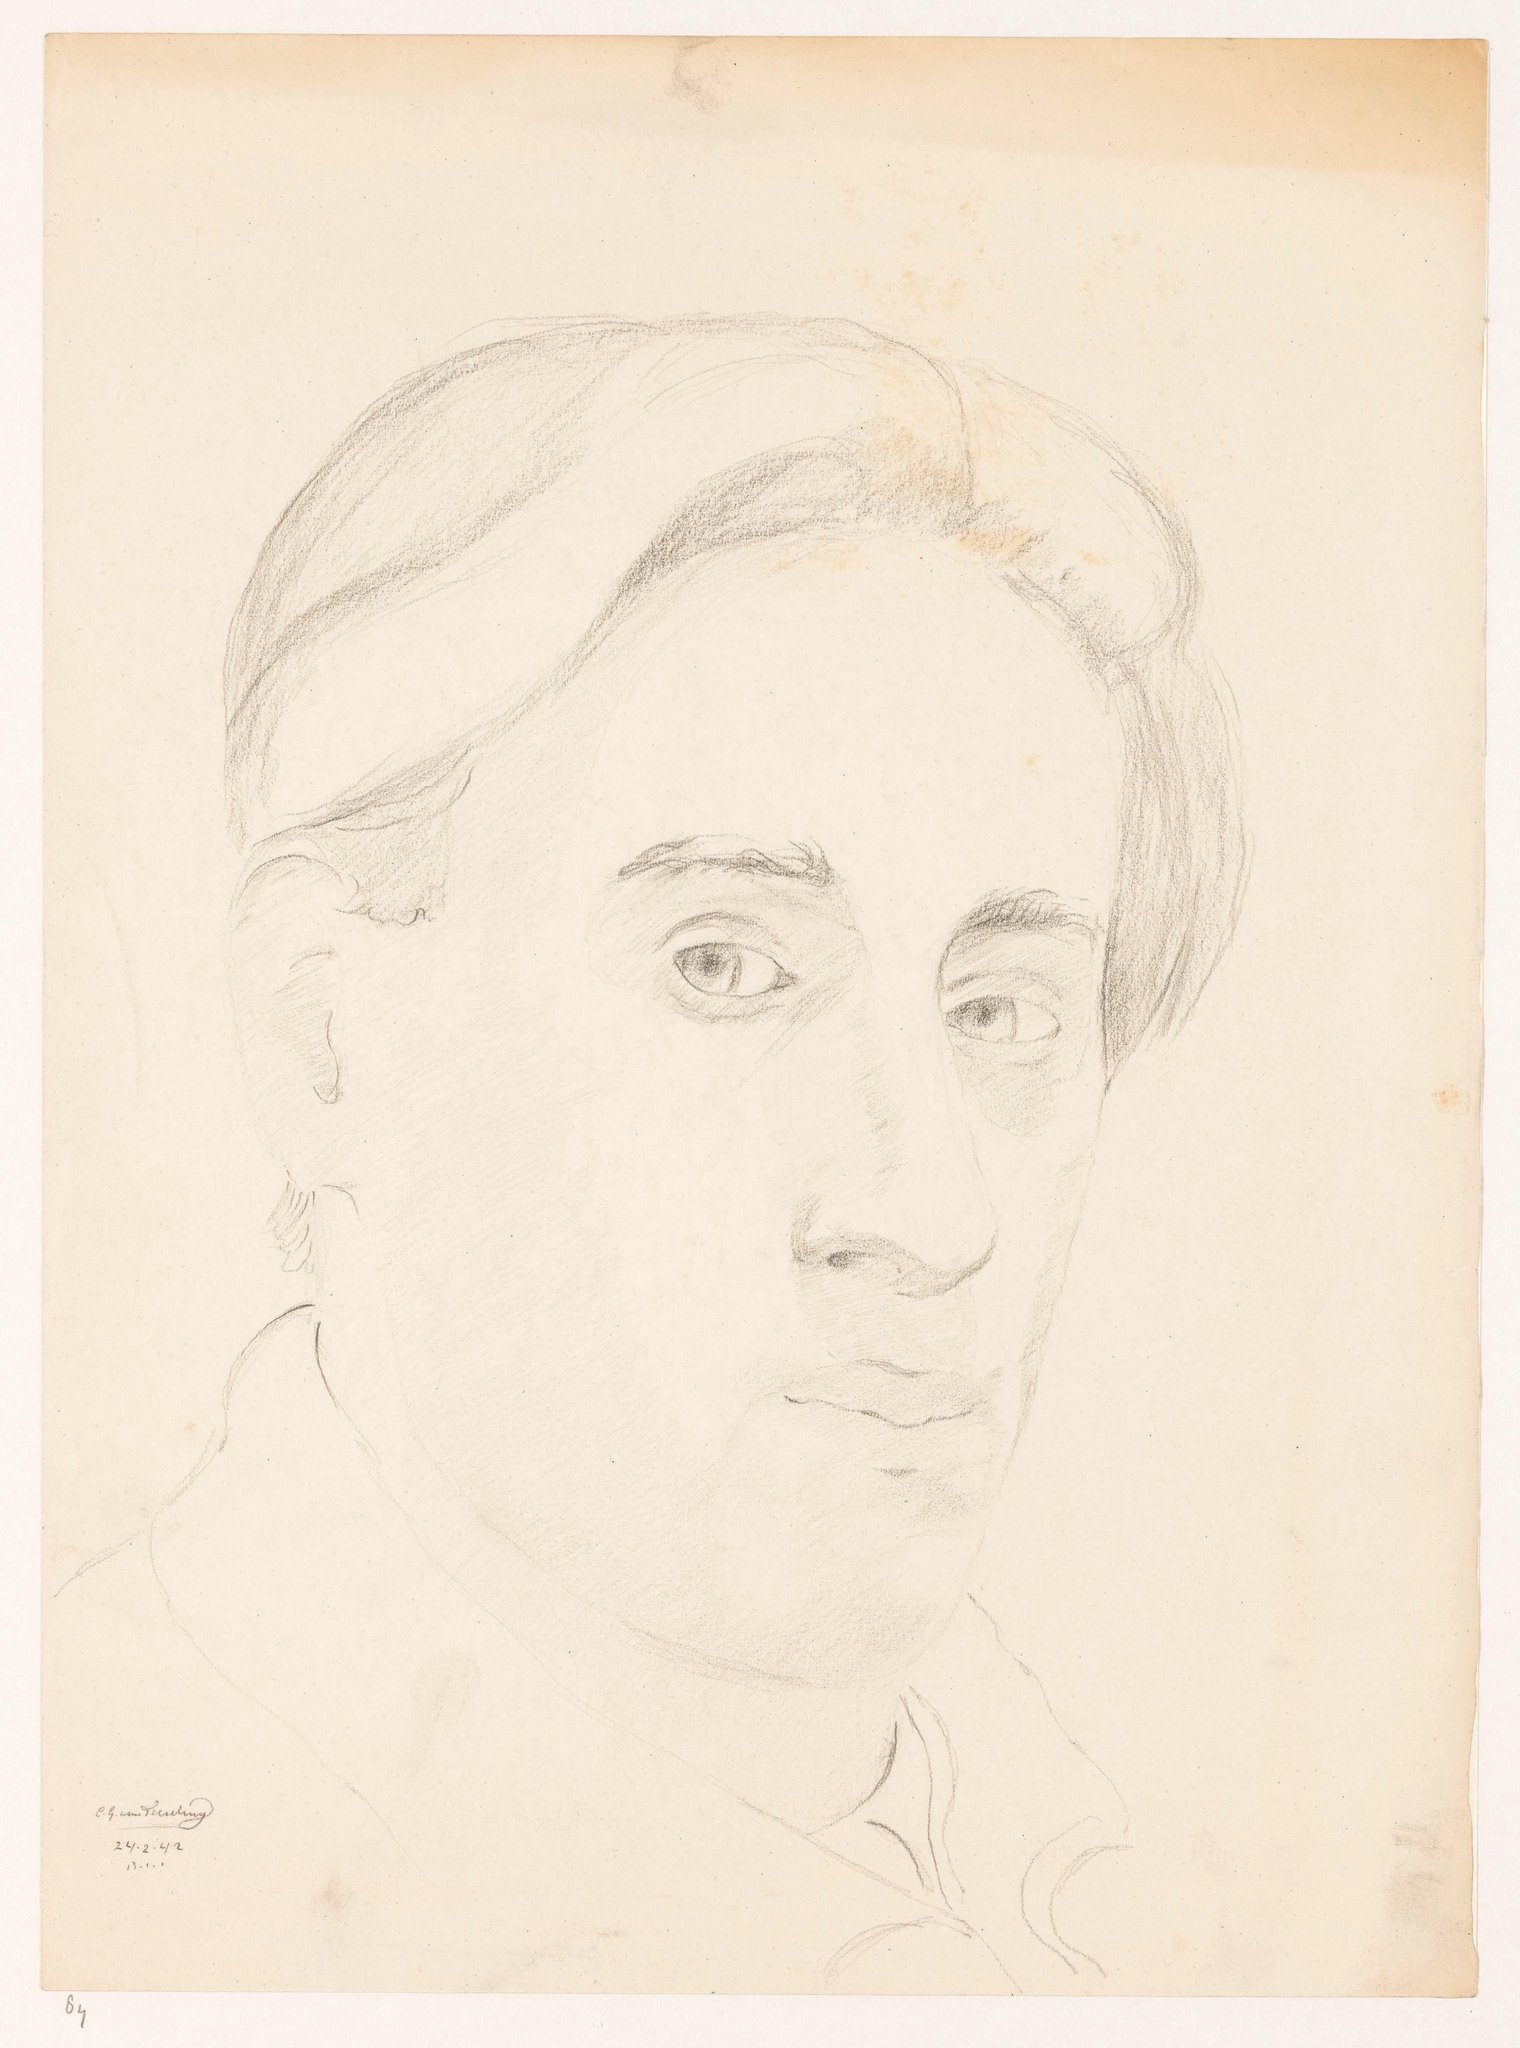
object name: drawing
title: Zelfportret: B-1-1, 24 februari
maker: cor van teeseling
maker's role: draughtsman, sculptor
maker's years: 1915-1942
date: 1942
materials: paper, pencil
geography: weteringschans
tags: amsterdam, draughtsman, sculptor, cor van teeseling, historical persons, prisoner in cell or locked place, portrait, self-portrait of draughtsman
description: Zelfportret van Cor van Teeseling: B-1-1, 24 februari. Getekend zelfportret van Cor van Teeseling driekwart zijn hoofd naar rechts gewend.